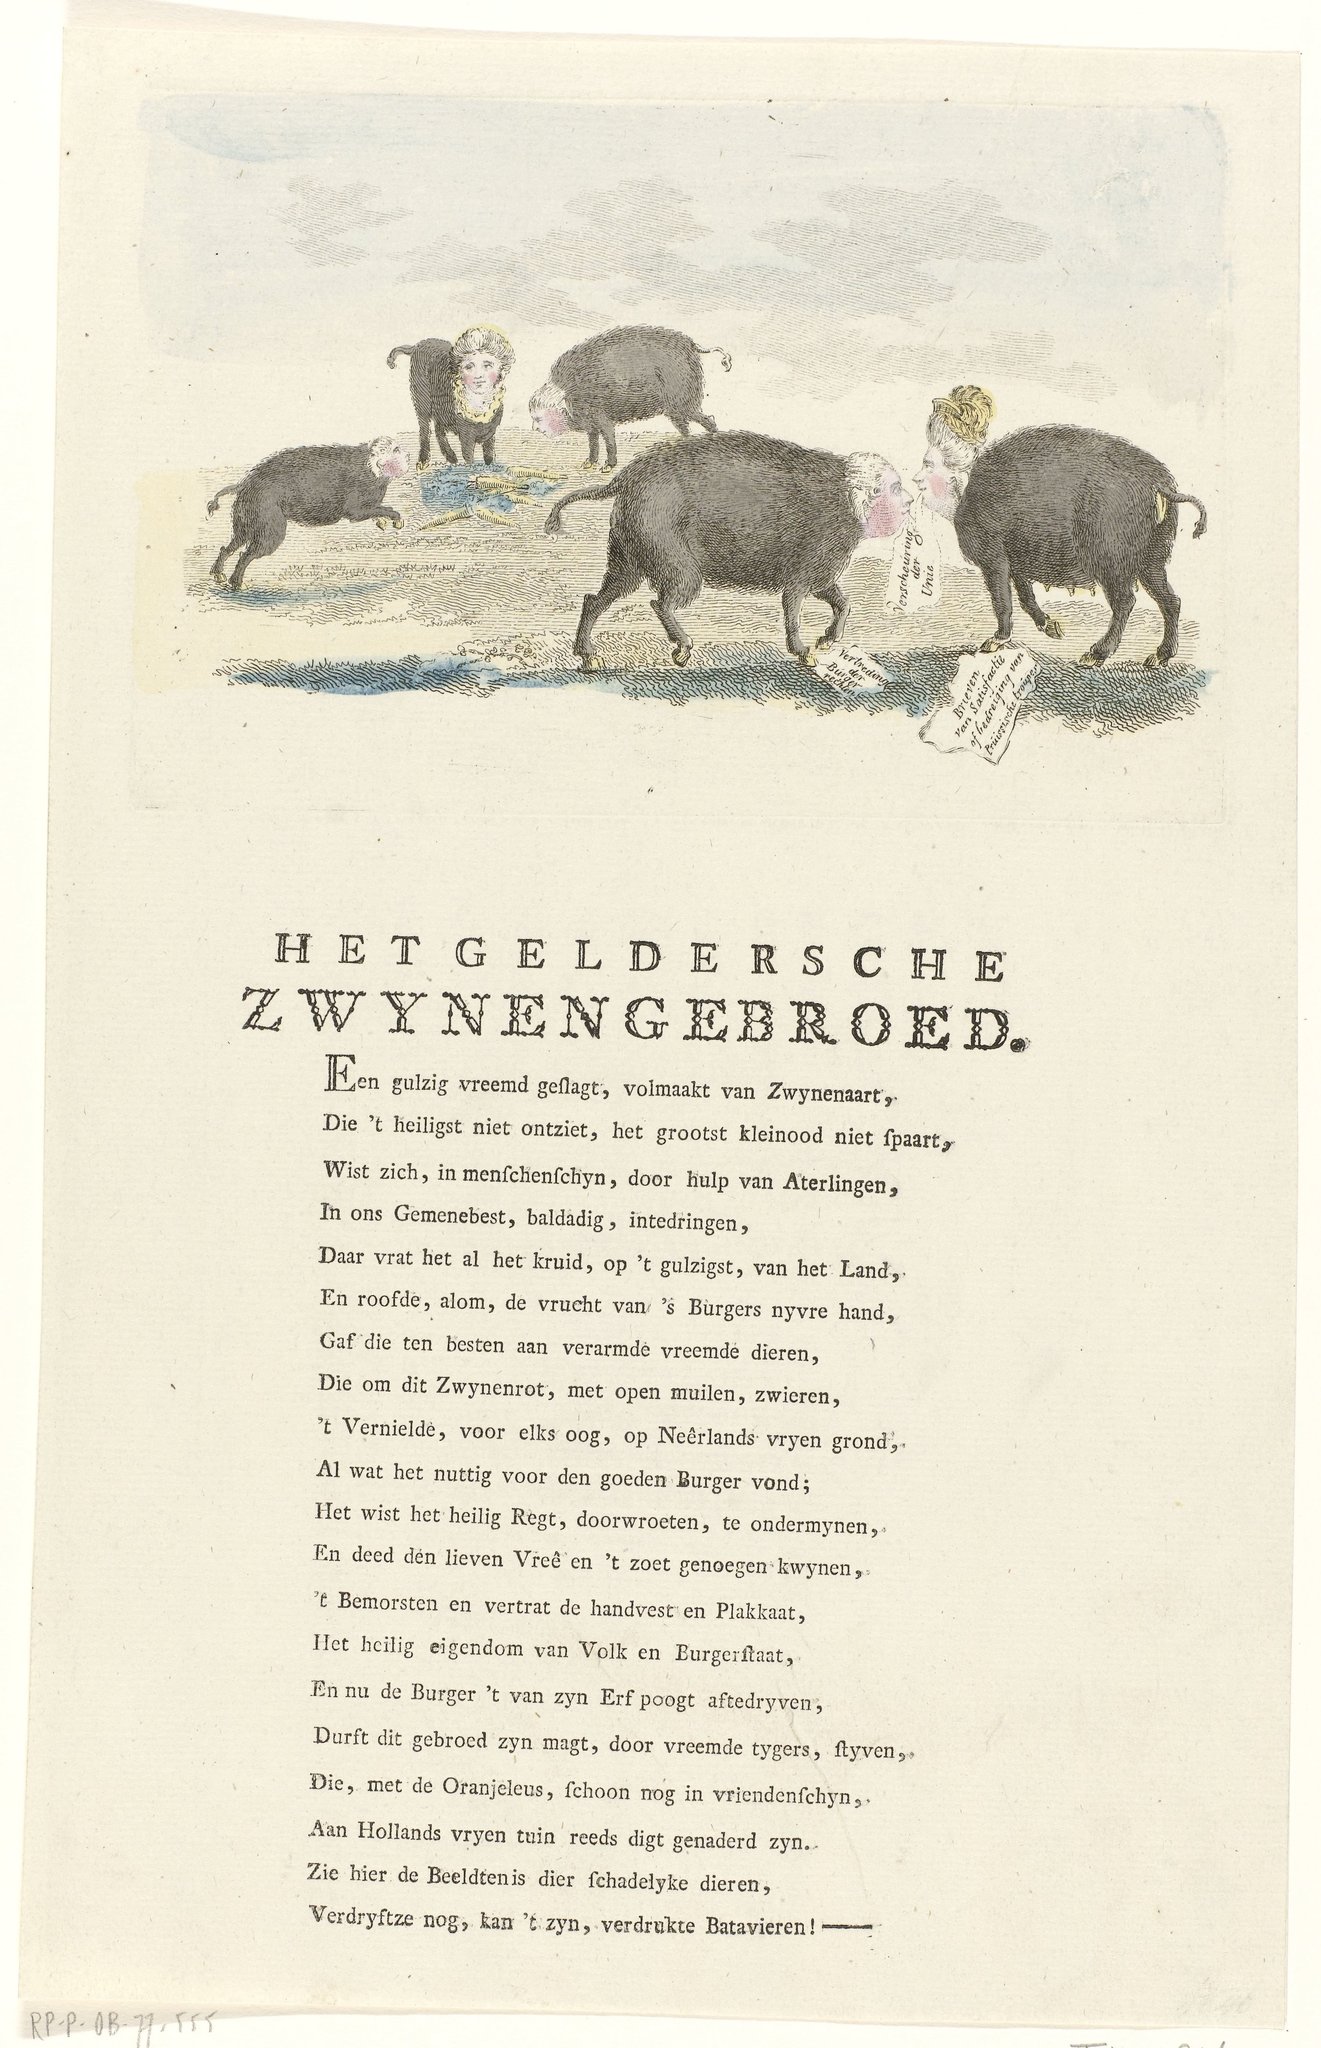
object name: print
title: Spotprent op Willem V en zijn vrouw en kinderen, 1787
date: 1787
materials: paper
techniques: engraving, etching, hand coloring, letterpress printing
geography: amsterdam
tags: the hague, william v (prince of orange), berlin, painter, wilhelmina of prussia (princess of orange), pig, animals acting as human beings, patriots (1780-1795)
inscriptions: collector's mark: Lugt 2228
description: Spotprent op Willem V, zijn vrouw en kinderen, naar aanleiding van de aanhouding van de prinses bij Goejanverwellesluis en de dreigende komst van Pruisische troepen, 1787. Een zwijn, een zeug en drie grote biggen met de gezichten van de Prins, zijn gemalin en zijn kinderen, lopen in een veld. De varkens verscheuren diverse bladen met teksten. Op het blad onder de plaat een spotvers van twintig regels.